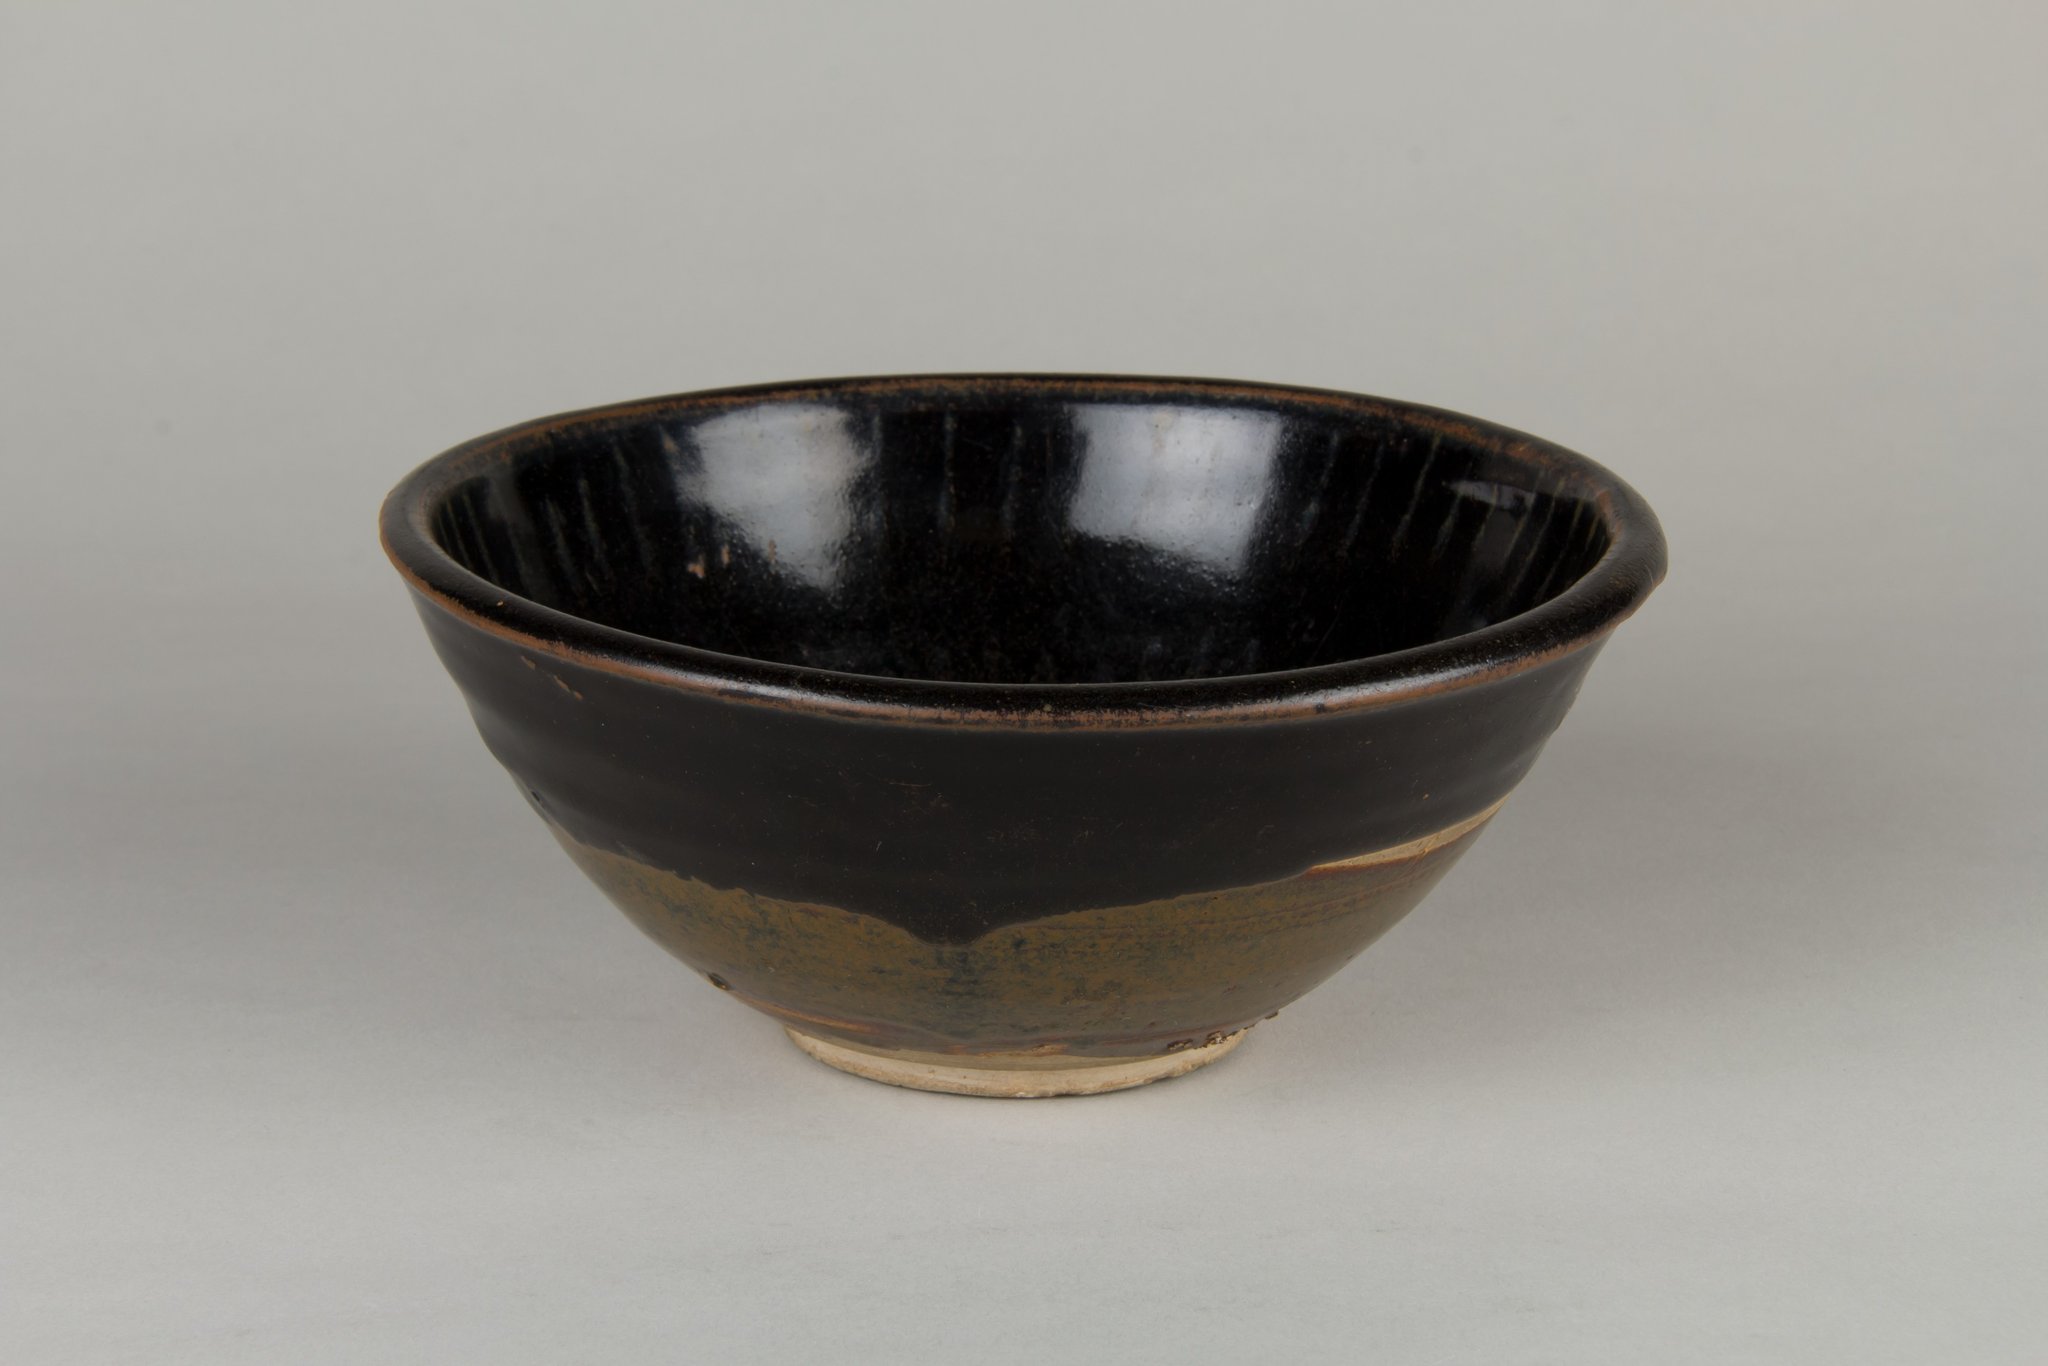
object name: bowl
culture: chinese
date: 960-1279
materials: glaze, stoneware